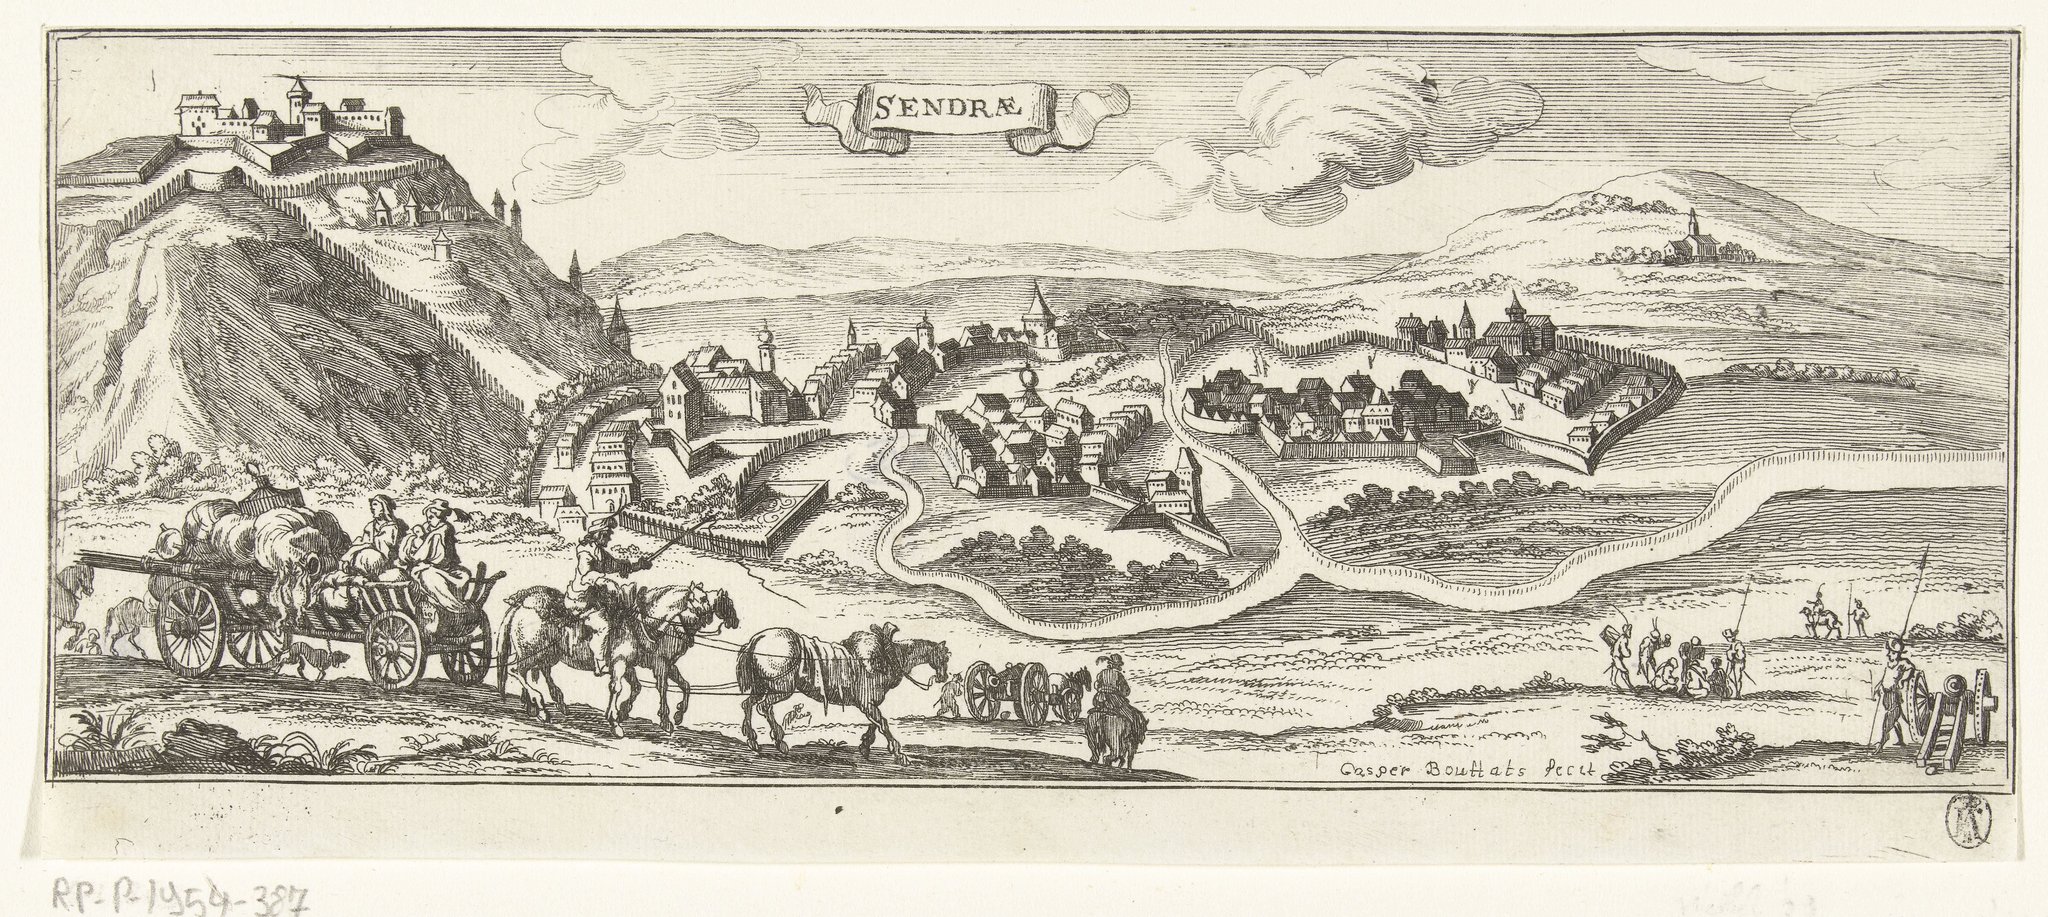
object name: print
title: Korte beschryvinghe, en de aen-wysinghe der plaetsen in desen boeck, met hunnen teghen woordighen standt, pertinentelijk uyt-ghebeldt, in Oostenryck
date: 1686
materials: paper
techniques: etching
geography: antwerp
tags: prospect of city, town panorama, silhouette of city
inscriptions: collector's mark: Lugt 2760, collector's mark: Lugt 2228, collector's mark: Lugt 971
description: illustriatie voor J. Peeters en C. Bouttats, "Korte beschryvinghe, en de aen-wysinghe der plaetsen in desen boeck, met hunnen teghen woordighen standt, pertinentelijk uyt-ghebeldt, in Oostenryck", Antwerpen 1686.